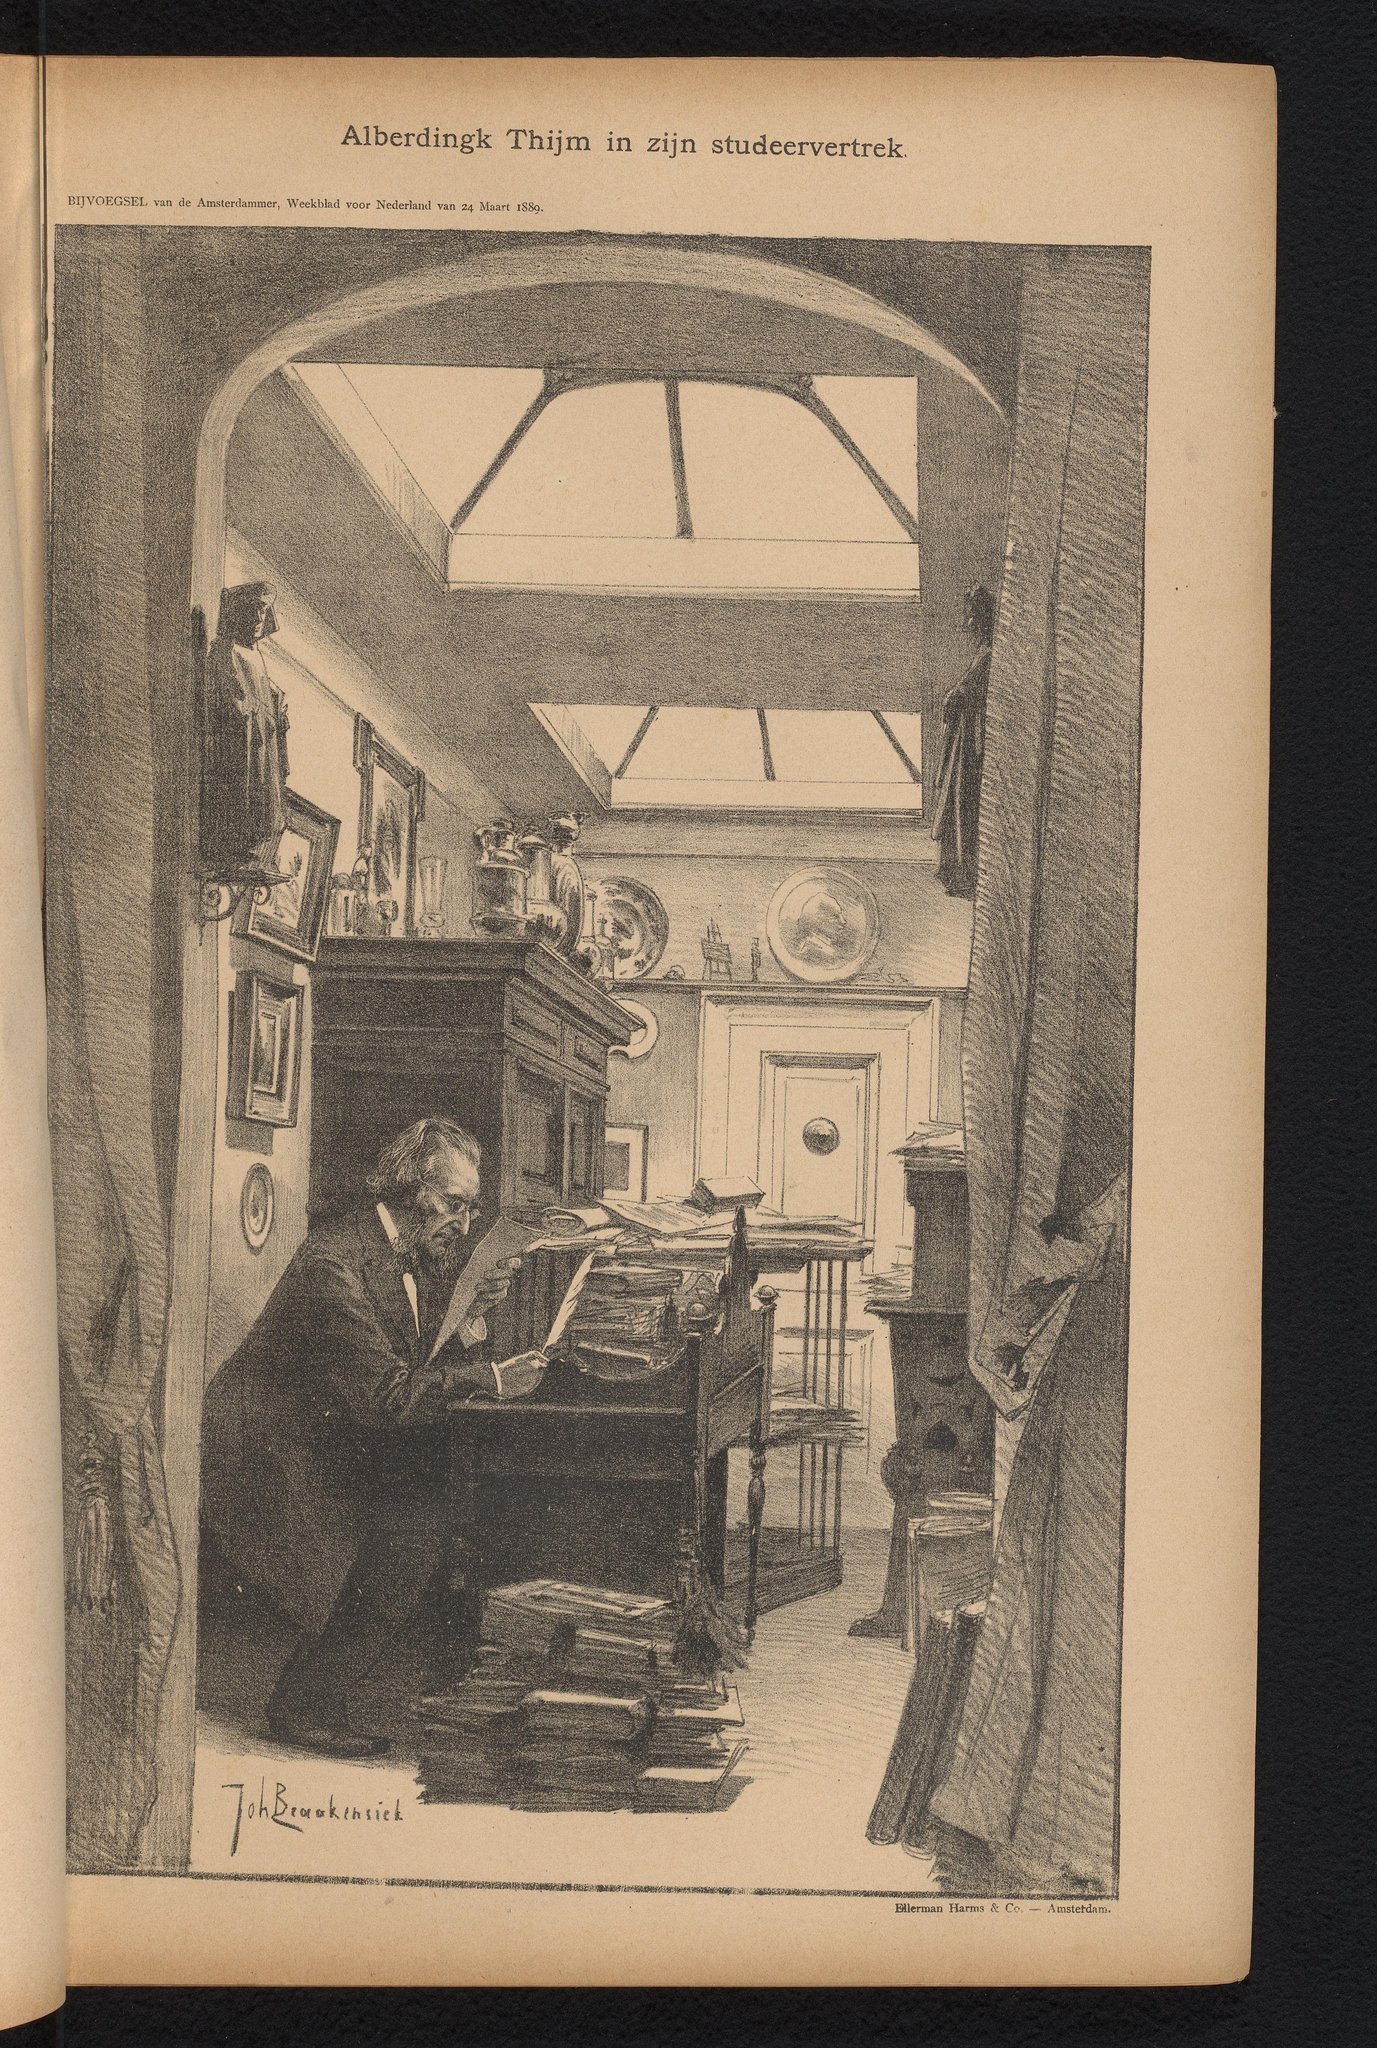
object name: print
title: Alberdingk Thijm in zijn studeervertrek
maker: johan braakensiek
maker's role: draughtsman, print maker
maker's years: 1858-1940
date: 1889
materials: paper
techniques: lithograph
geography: amsterdam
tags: amsterdam, painter, publisher, josephus albertus alberdingk thijm, scholar in his study, historical persons, writer, poet, author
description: Portret van de schrijver en letterkundige Joseph Alberdingk Thijm aan het werk in zijn studeervertrek. Bij zijn overlijden op 17 maart 1889.